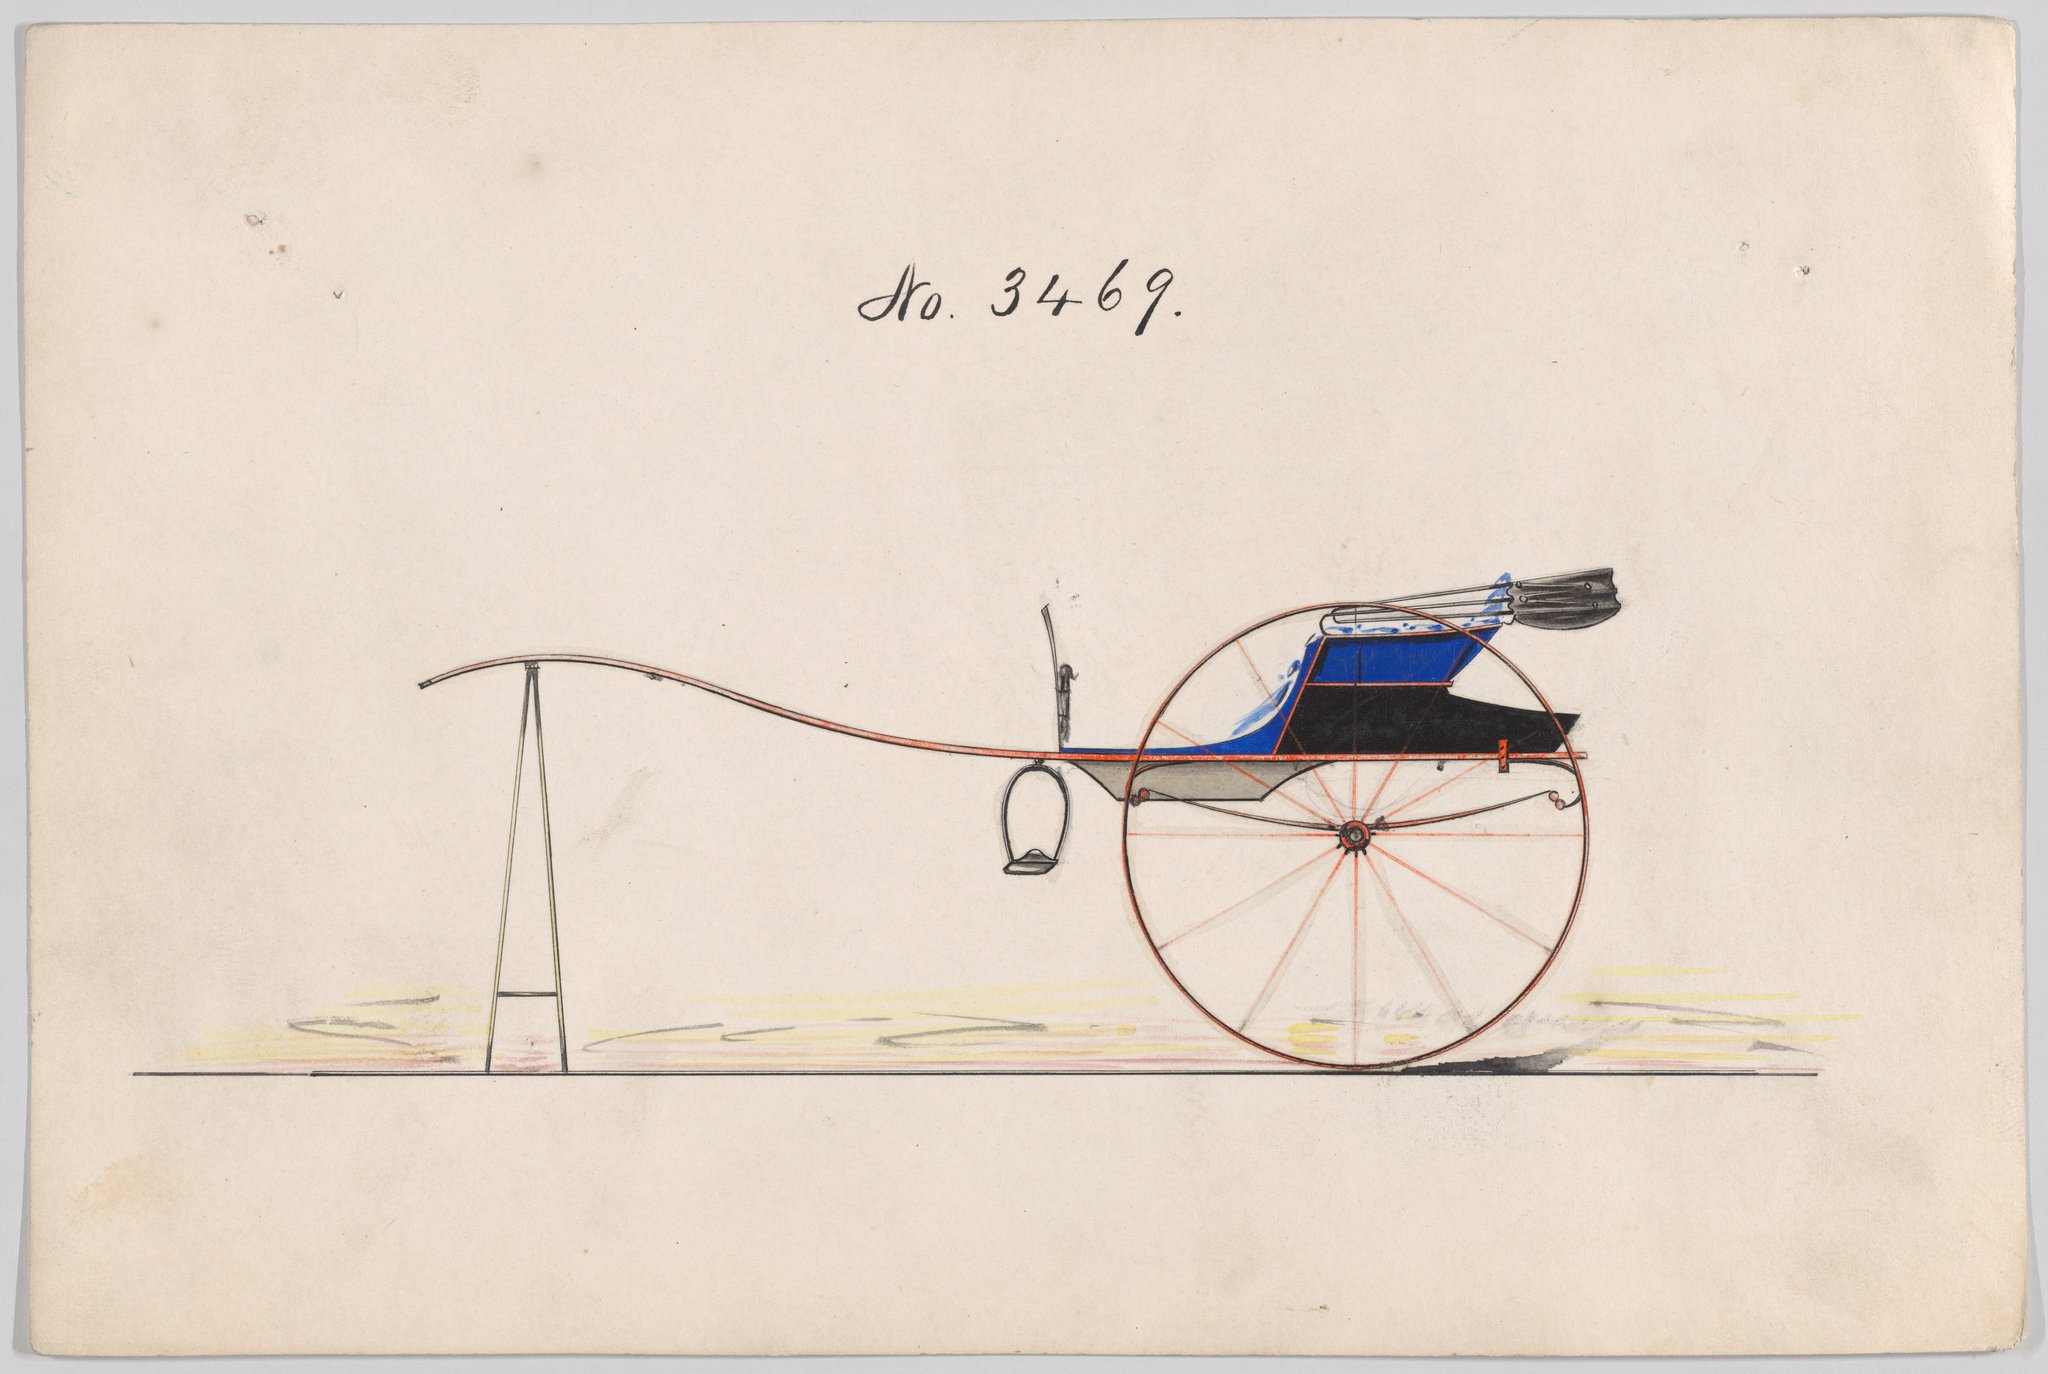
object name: drawing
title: Gig # 3469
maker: brewster & co.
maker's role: manufacturer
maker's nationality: american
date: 1878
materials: gouache, ink, watercolor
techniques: pen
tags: carriages